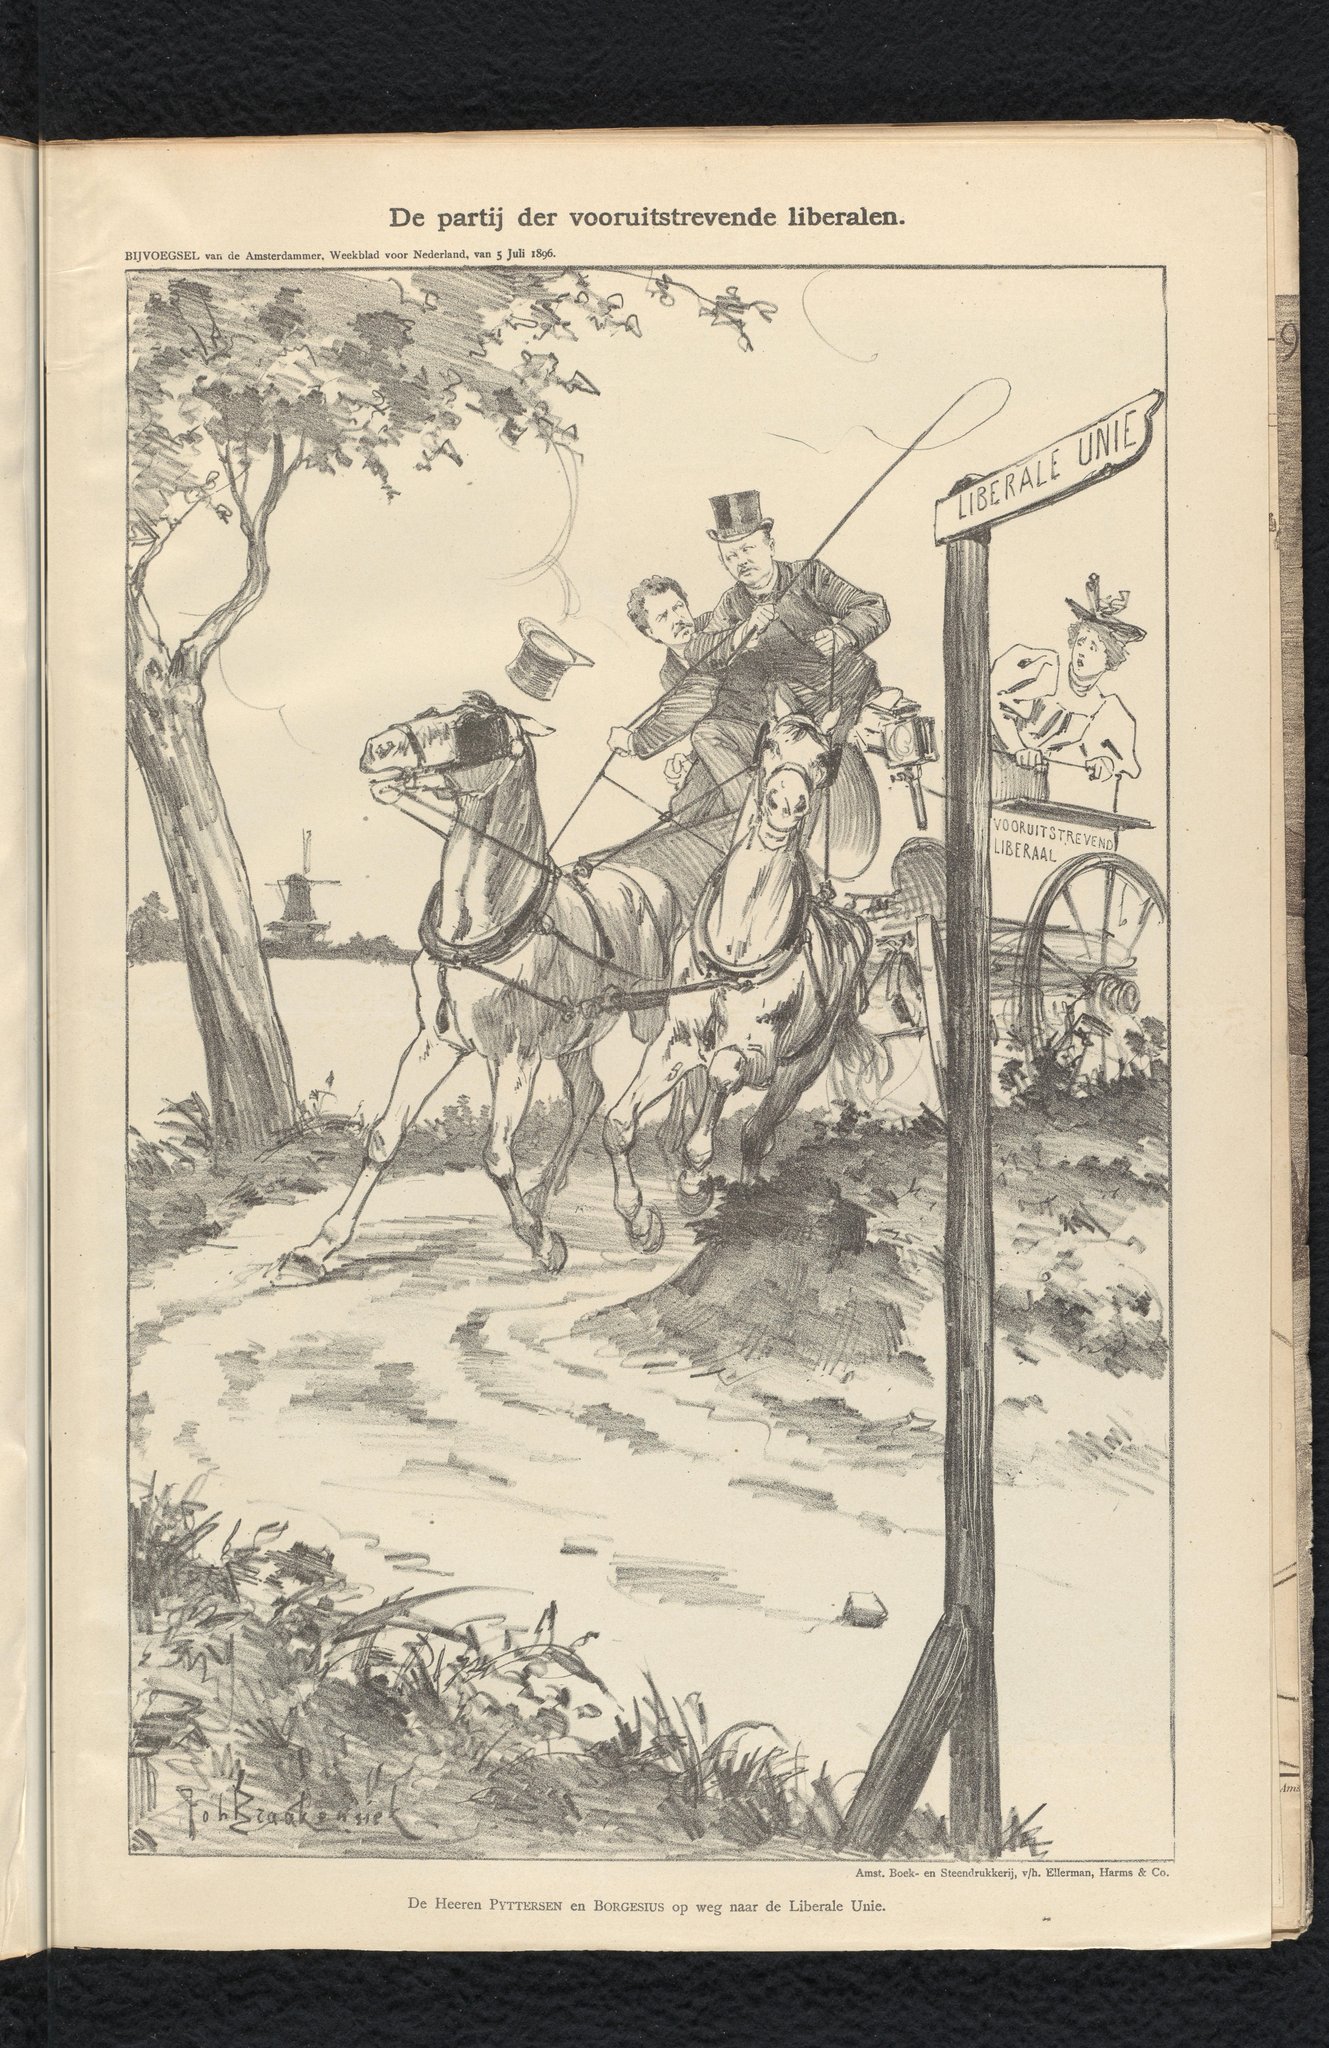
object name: cartoon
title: De partij der vooruitstrevende liberalen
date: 1896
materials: paper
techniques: lithograph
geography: netherlands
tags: politician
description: De koetsiers Pyttersen en Borgesius worstelen met elkaar om controle te krijgen over de op hol geslagen kar van de 'vooruitstrevende liberalen'.